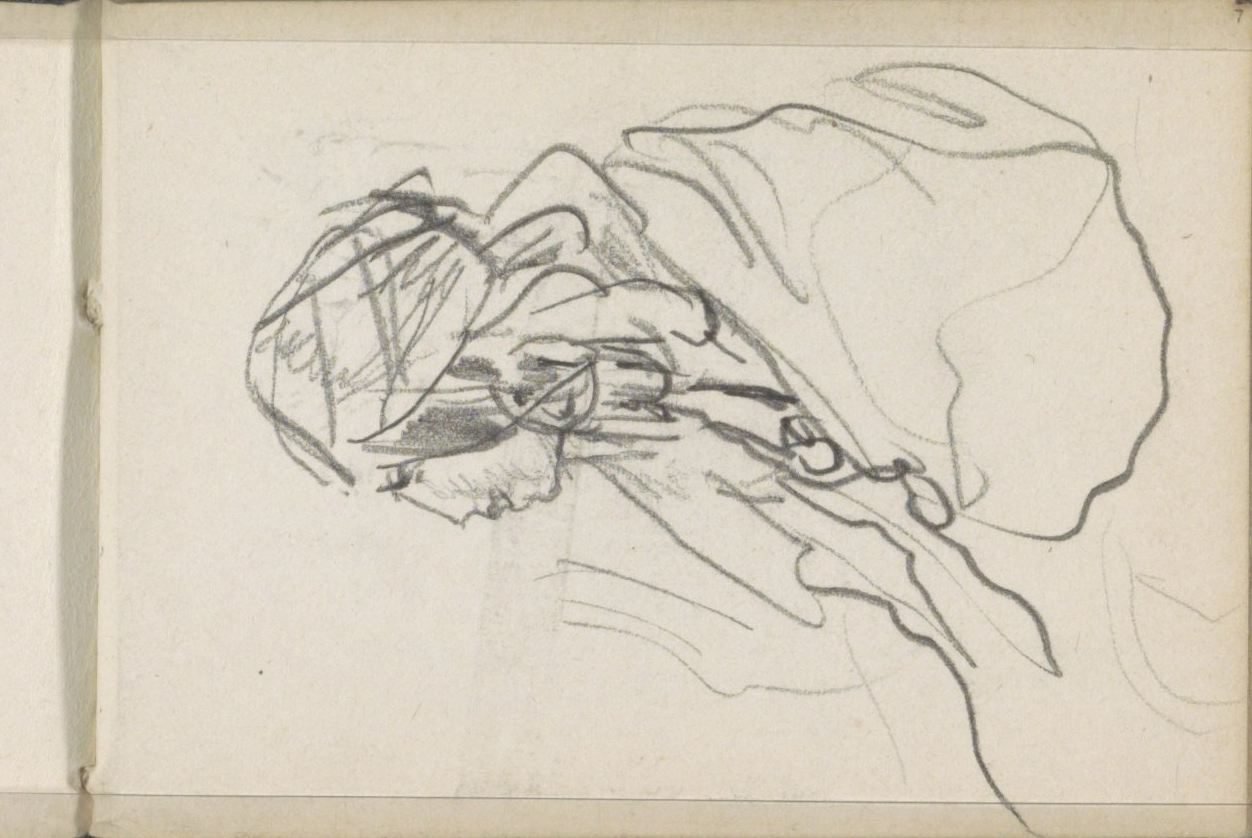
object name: sketchbook leaf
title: Algerijnse vrouw, ten halven lijve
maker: marius bauer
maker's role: draughtsman, print maker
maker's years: 1867-1932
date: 1922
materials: paper, pencil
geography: biskra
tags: adult woman, head-gear (with name), africans, ear-rings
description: De figuur draagt een sluier om het hoofd en oorbellen. Pagina 7 uit een schetsboek met 32 bladen.